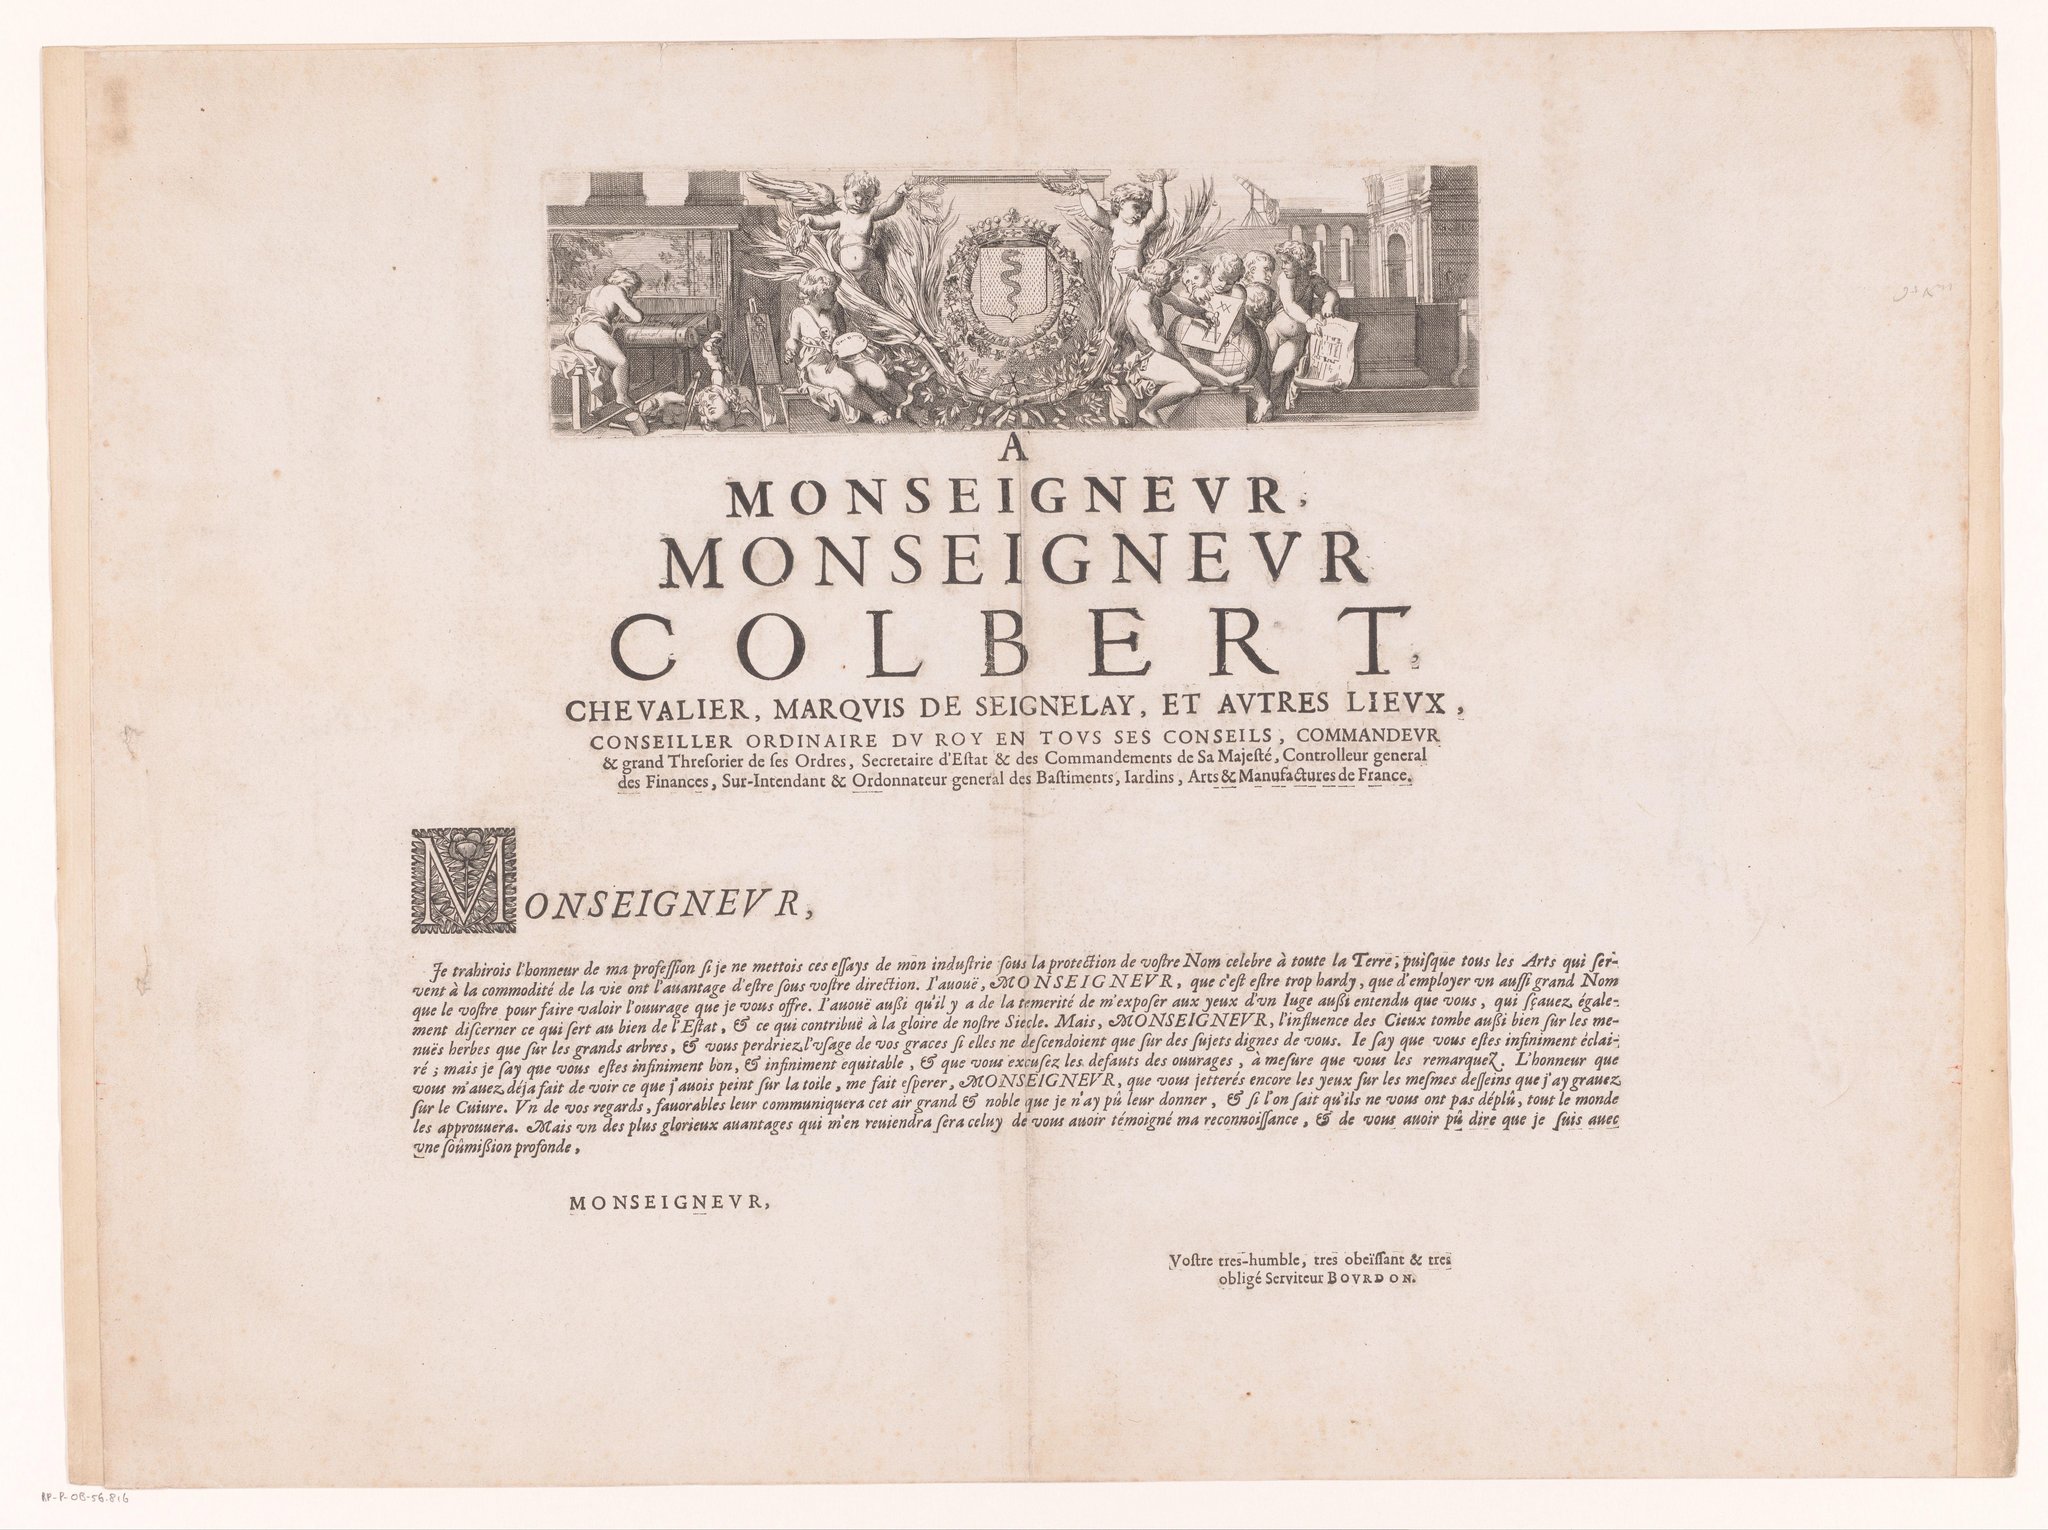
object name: print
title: Putti actief in verschillende kunsten en putti met lauwerkransen om een wapenschild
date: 1626-1671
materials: paper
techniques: engraving, etching, letterpress printing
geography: france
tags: the liberal arts, 'artes liberales', cupids: 'amores', 'amoretti', 'putti', tapestry weaver, gobelin maker, armorial bearing, heraldry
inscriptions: collector's mark: Lugt 240, watermark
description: Putti actief in verschillende kunsten en putti met lauwerkransen om een wapenschild op een blad met een opdracht aan Jean-Baptiste Colbert.